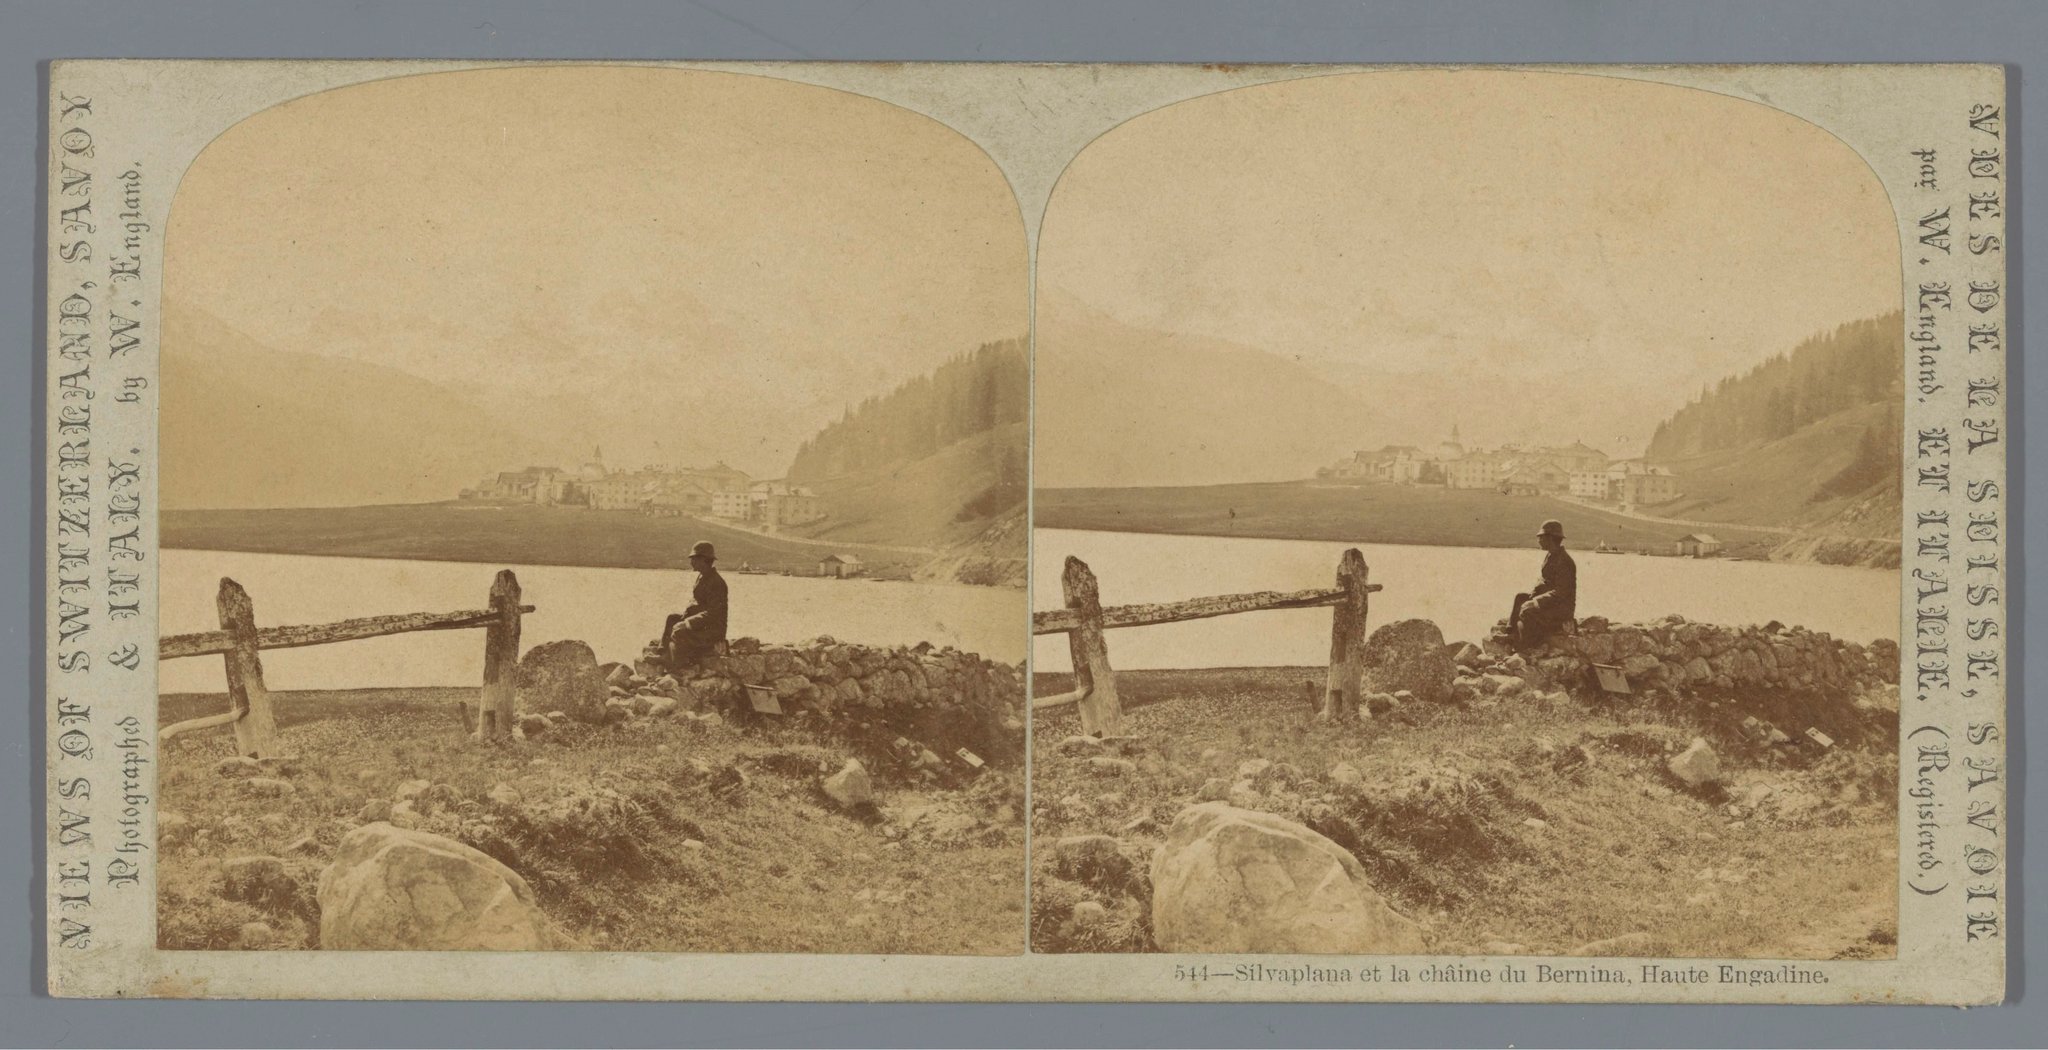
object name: stereograph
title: Gezicht op Silvaplana en het Berninamassief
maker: william england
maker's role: fotograaf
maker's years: 1816-1896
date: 1850-1880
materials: cardboard, photographic support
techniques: albumen print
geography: switzerland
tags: lake, mountains (+ landscape with figures, staffage)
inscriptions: number: ‘544’, inscription: ‘Vues de la Suisse, Savoie et Italie’